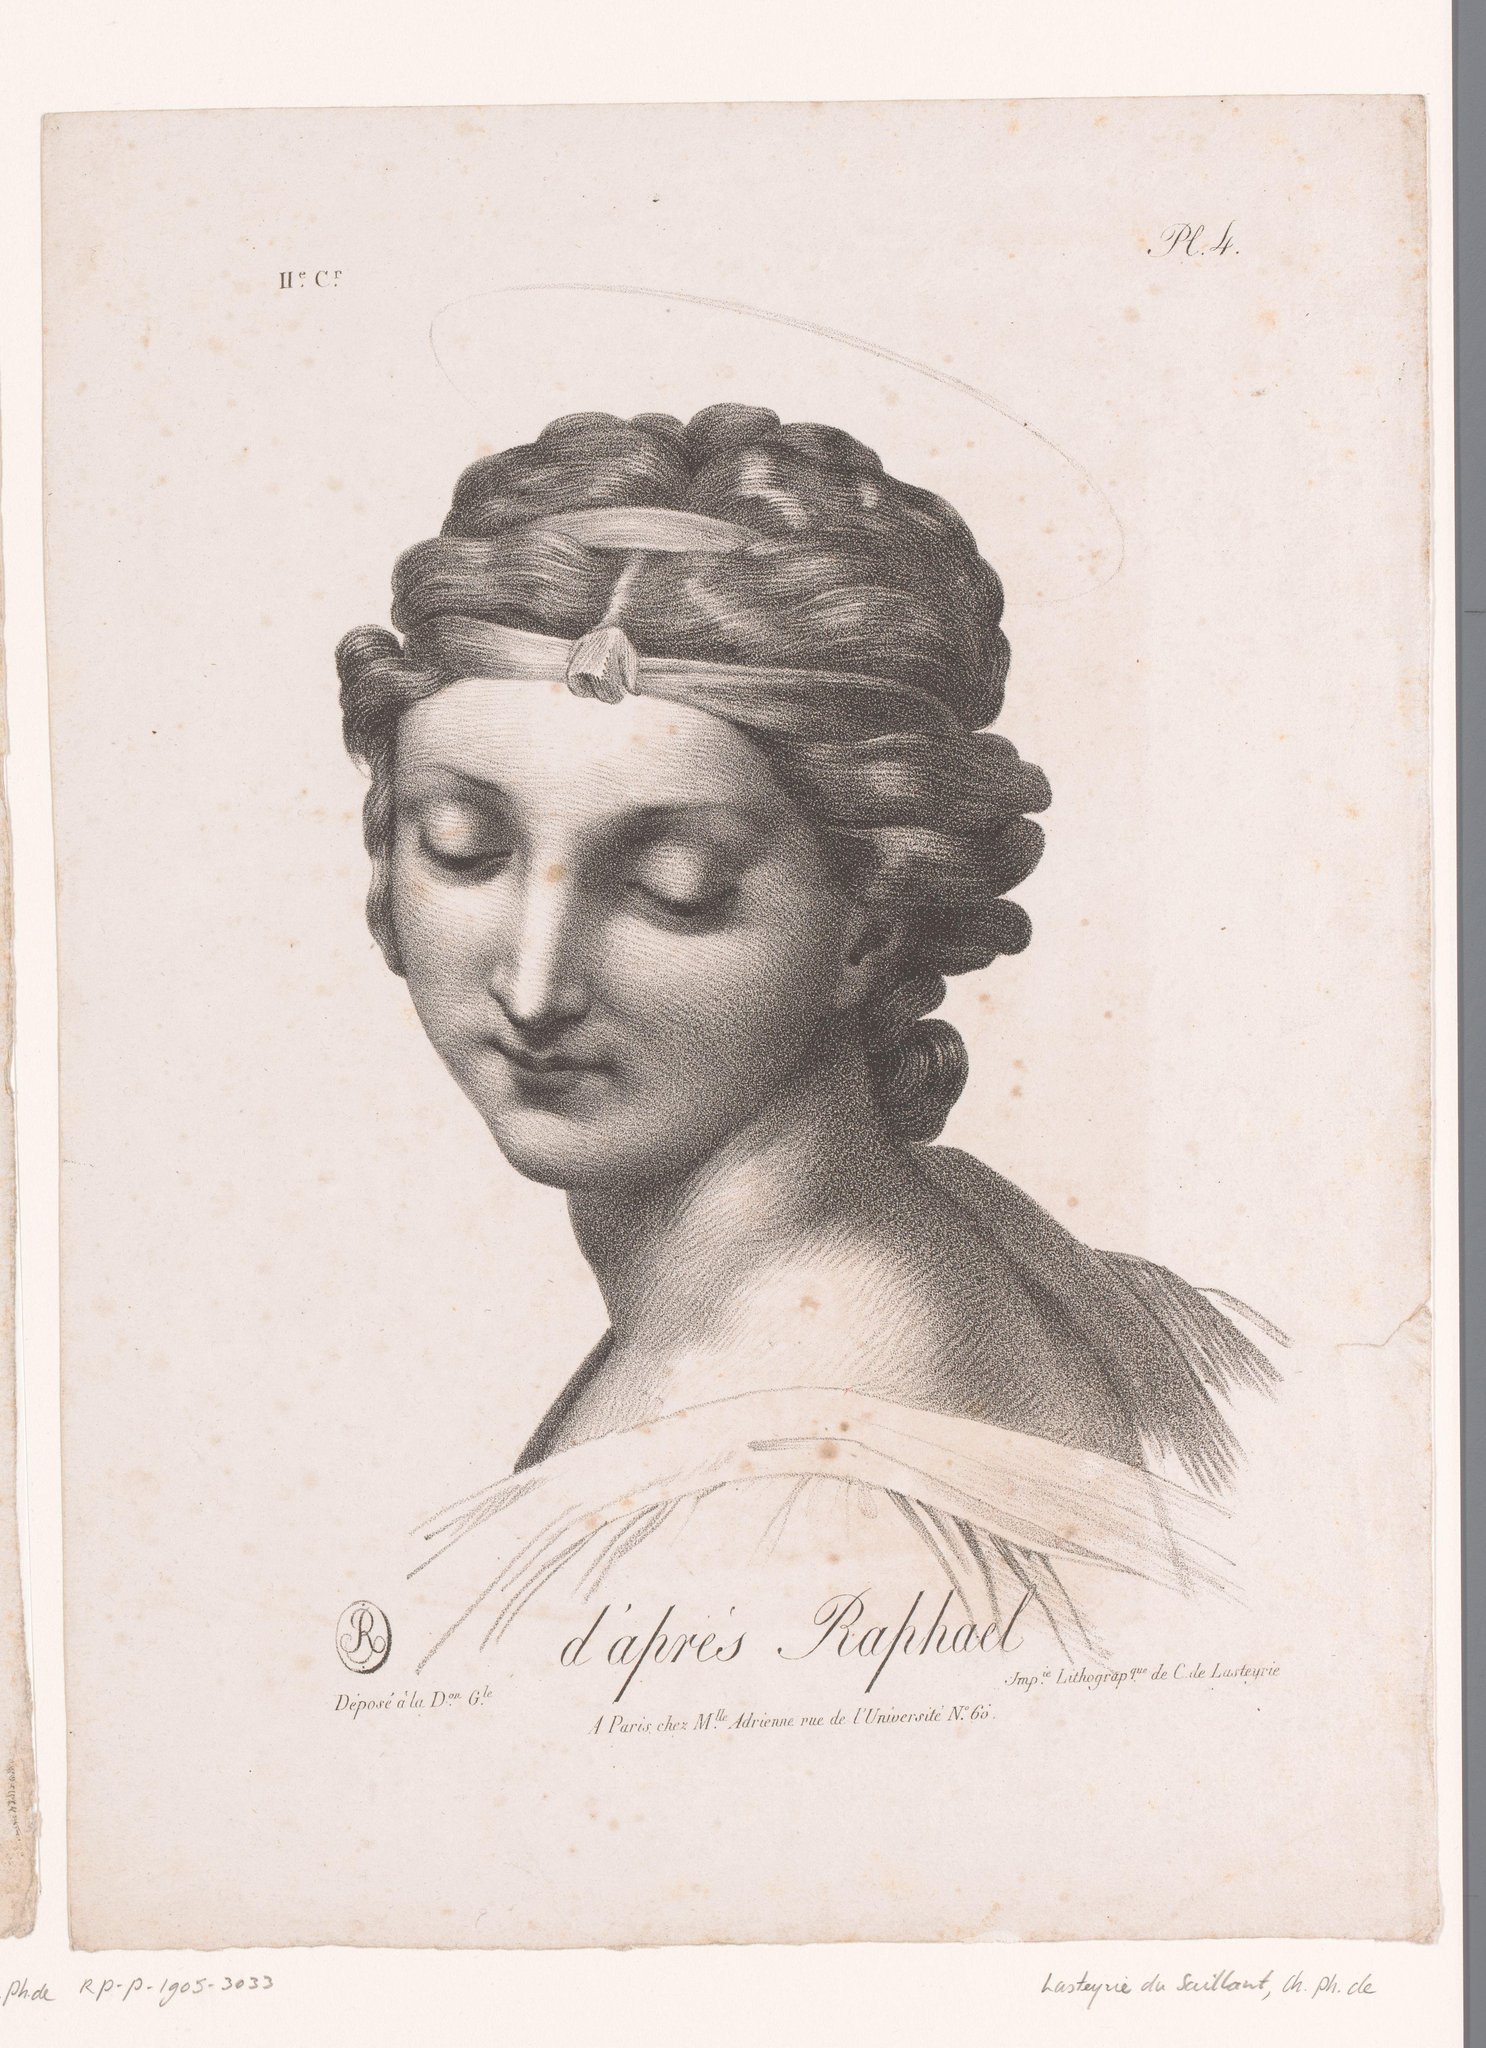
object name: print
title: D'après Raphael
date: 1812-1830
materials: paper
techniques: lithograph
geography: paris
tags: anonymous historical person portrayed, head (human) - aa - female human figure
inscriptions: collector's mark: Lugt 2228a